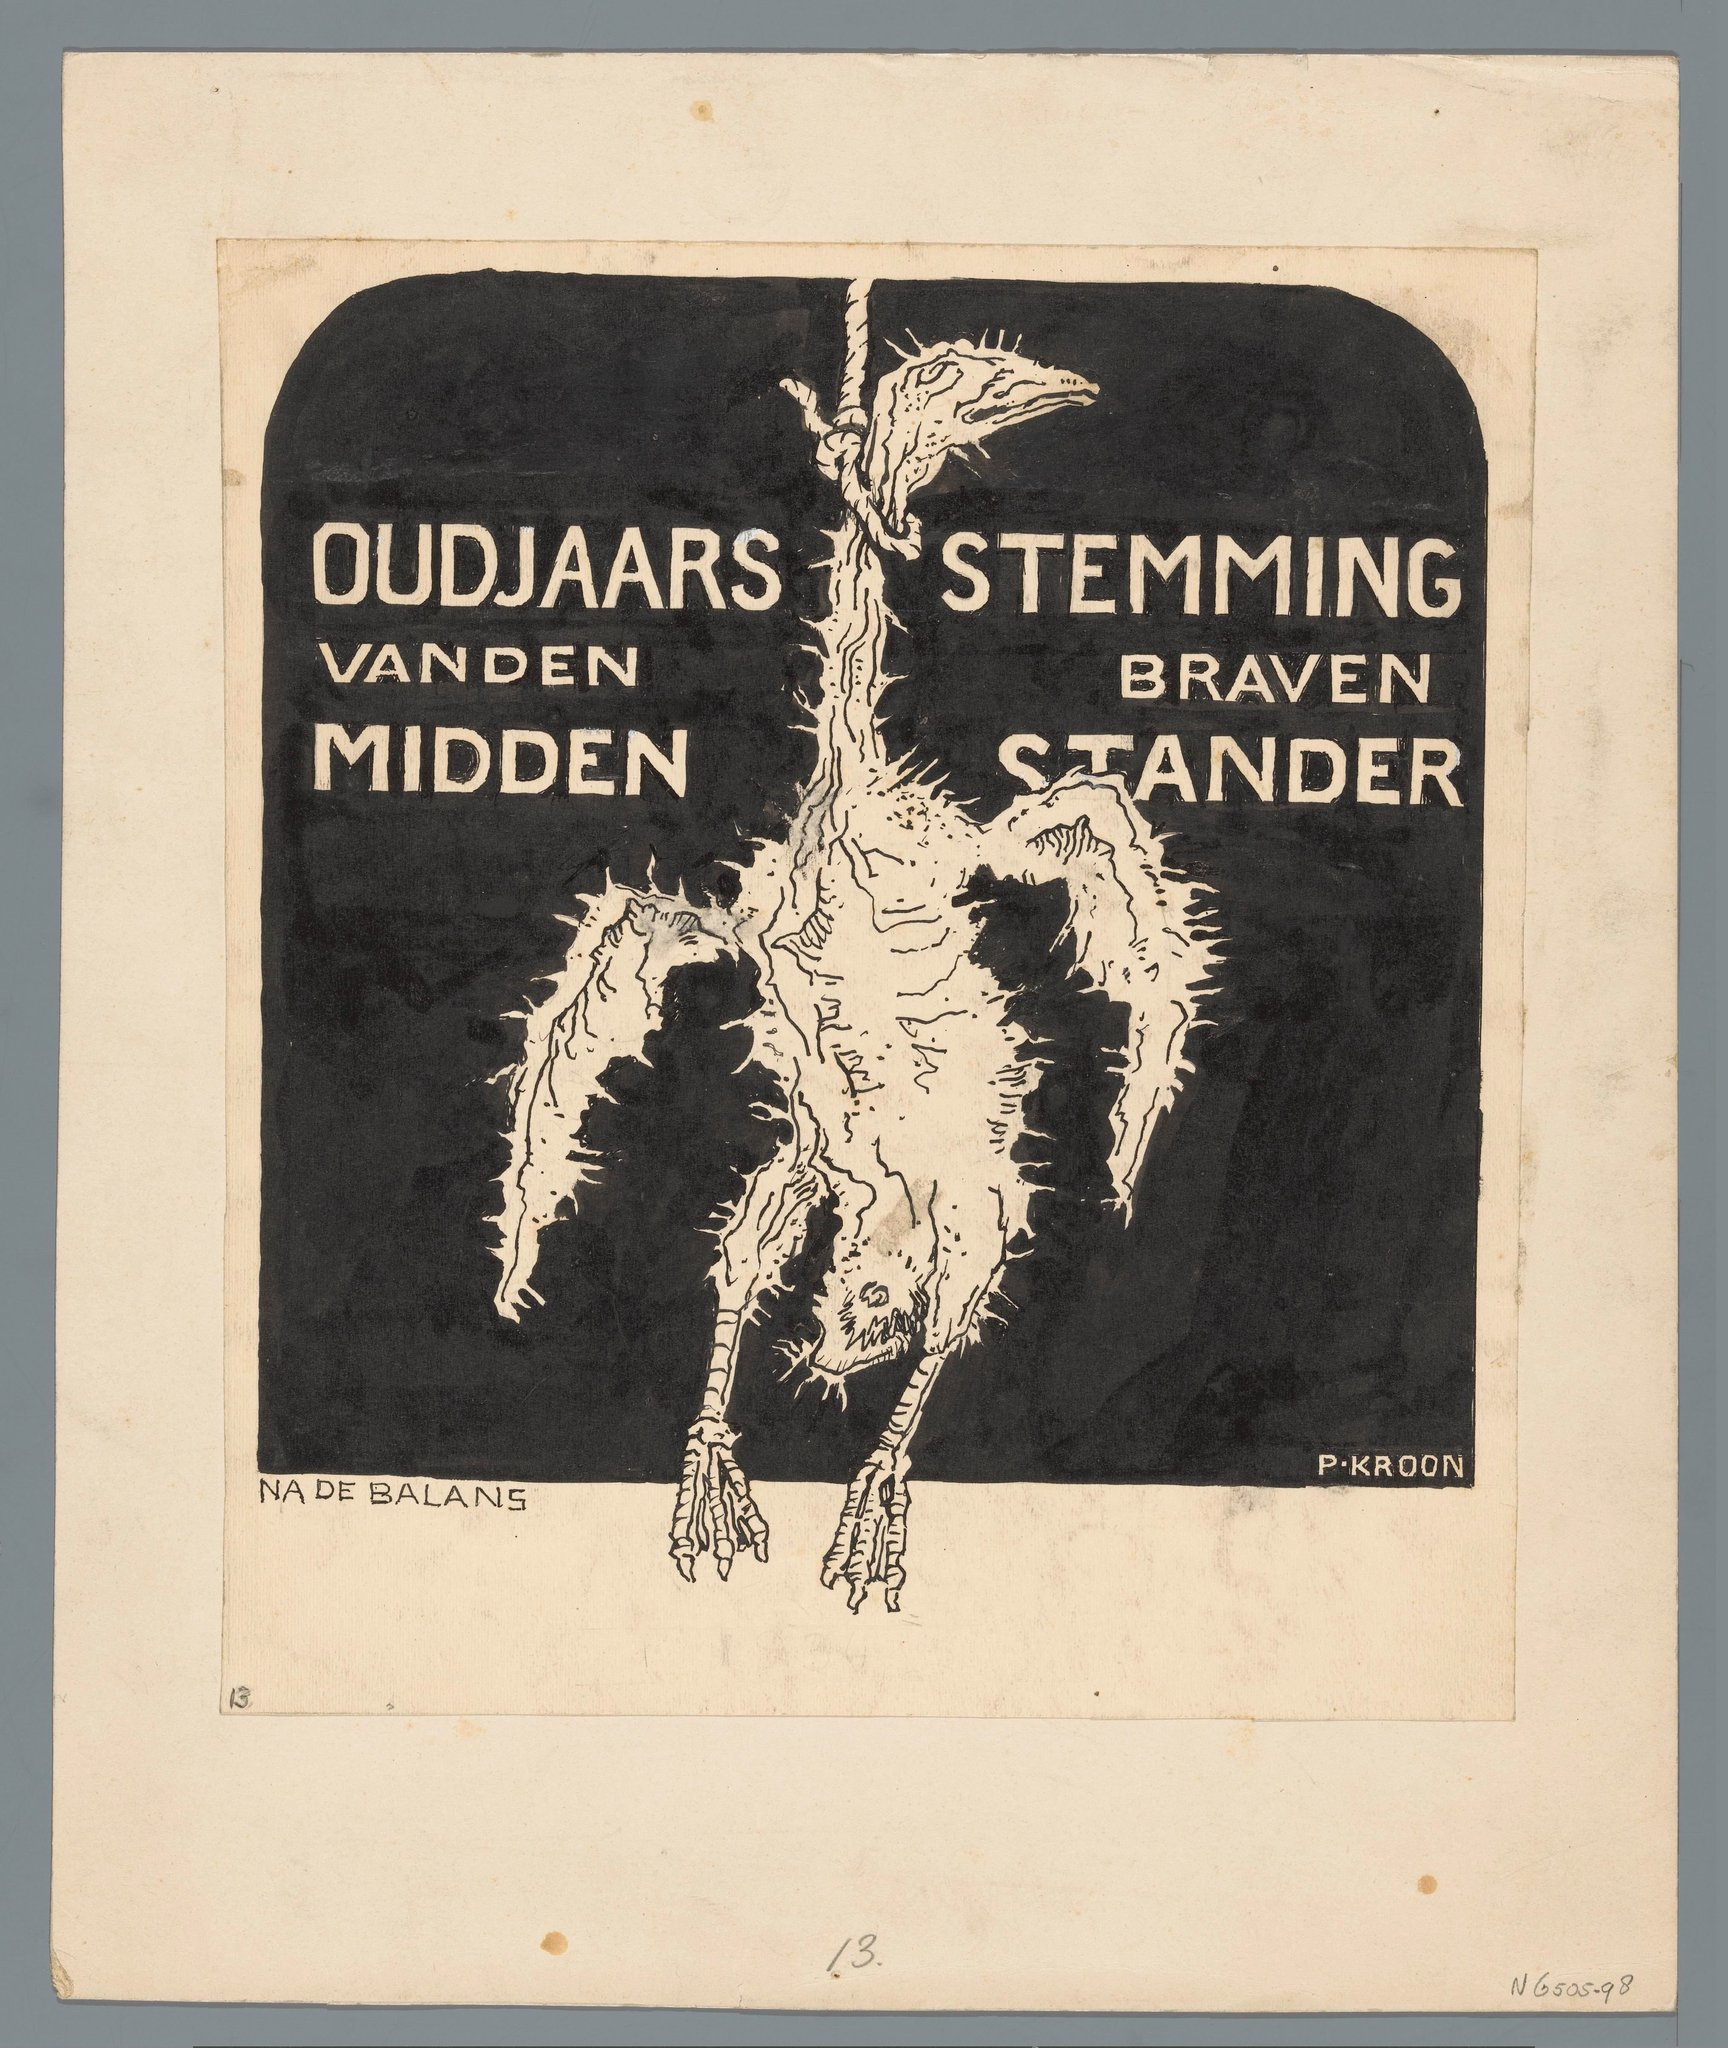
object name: drawing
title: Oudejaaarsstemming van den braven Middenstander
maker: patricq kroon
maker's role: draughtsman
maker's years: 1862-1941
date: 1900-1935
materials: ink, paper, pencil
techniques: brush, pen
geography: netherlands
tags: fowl (cock, hen, chicken, etc.), plucked fowl, political caricatures and satires, netherlands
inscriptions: inscription: ‘Oudejaaarsstemming van den braven Middenstander / Na de balans’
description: Een aan zijn nek opgehangen kaalgeplukte kip, als symbool voor de stemming onder de middenstanders na het opmaken van de balans aan het einde van het jaar, Ontwerp voor een politieke spotprent.